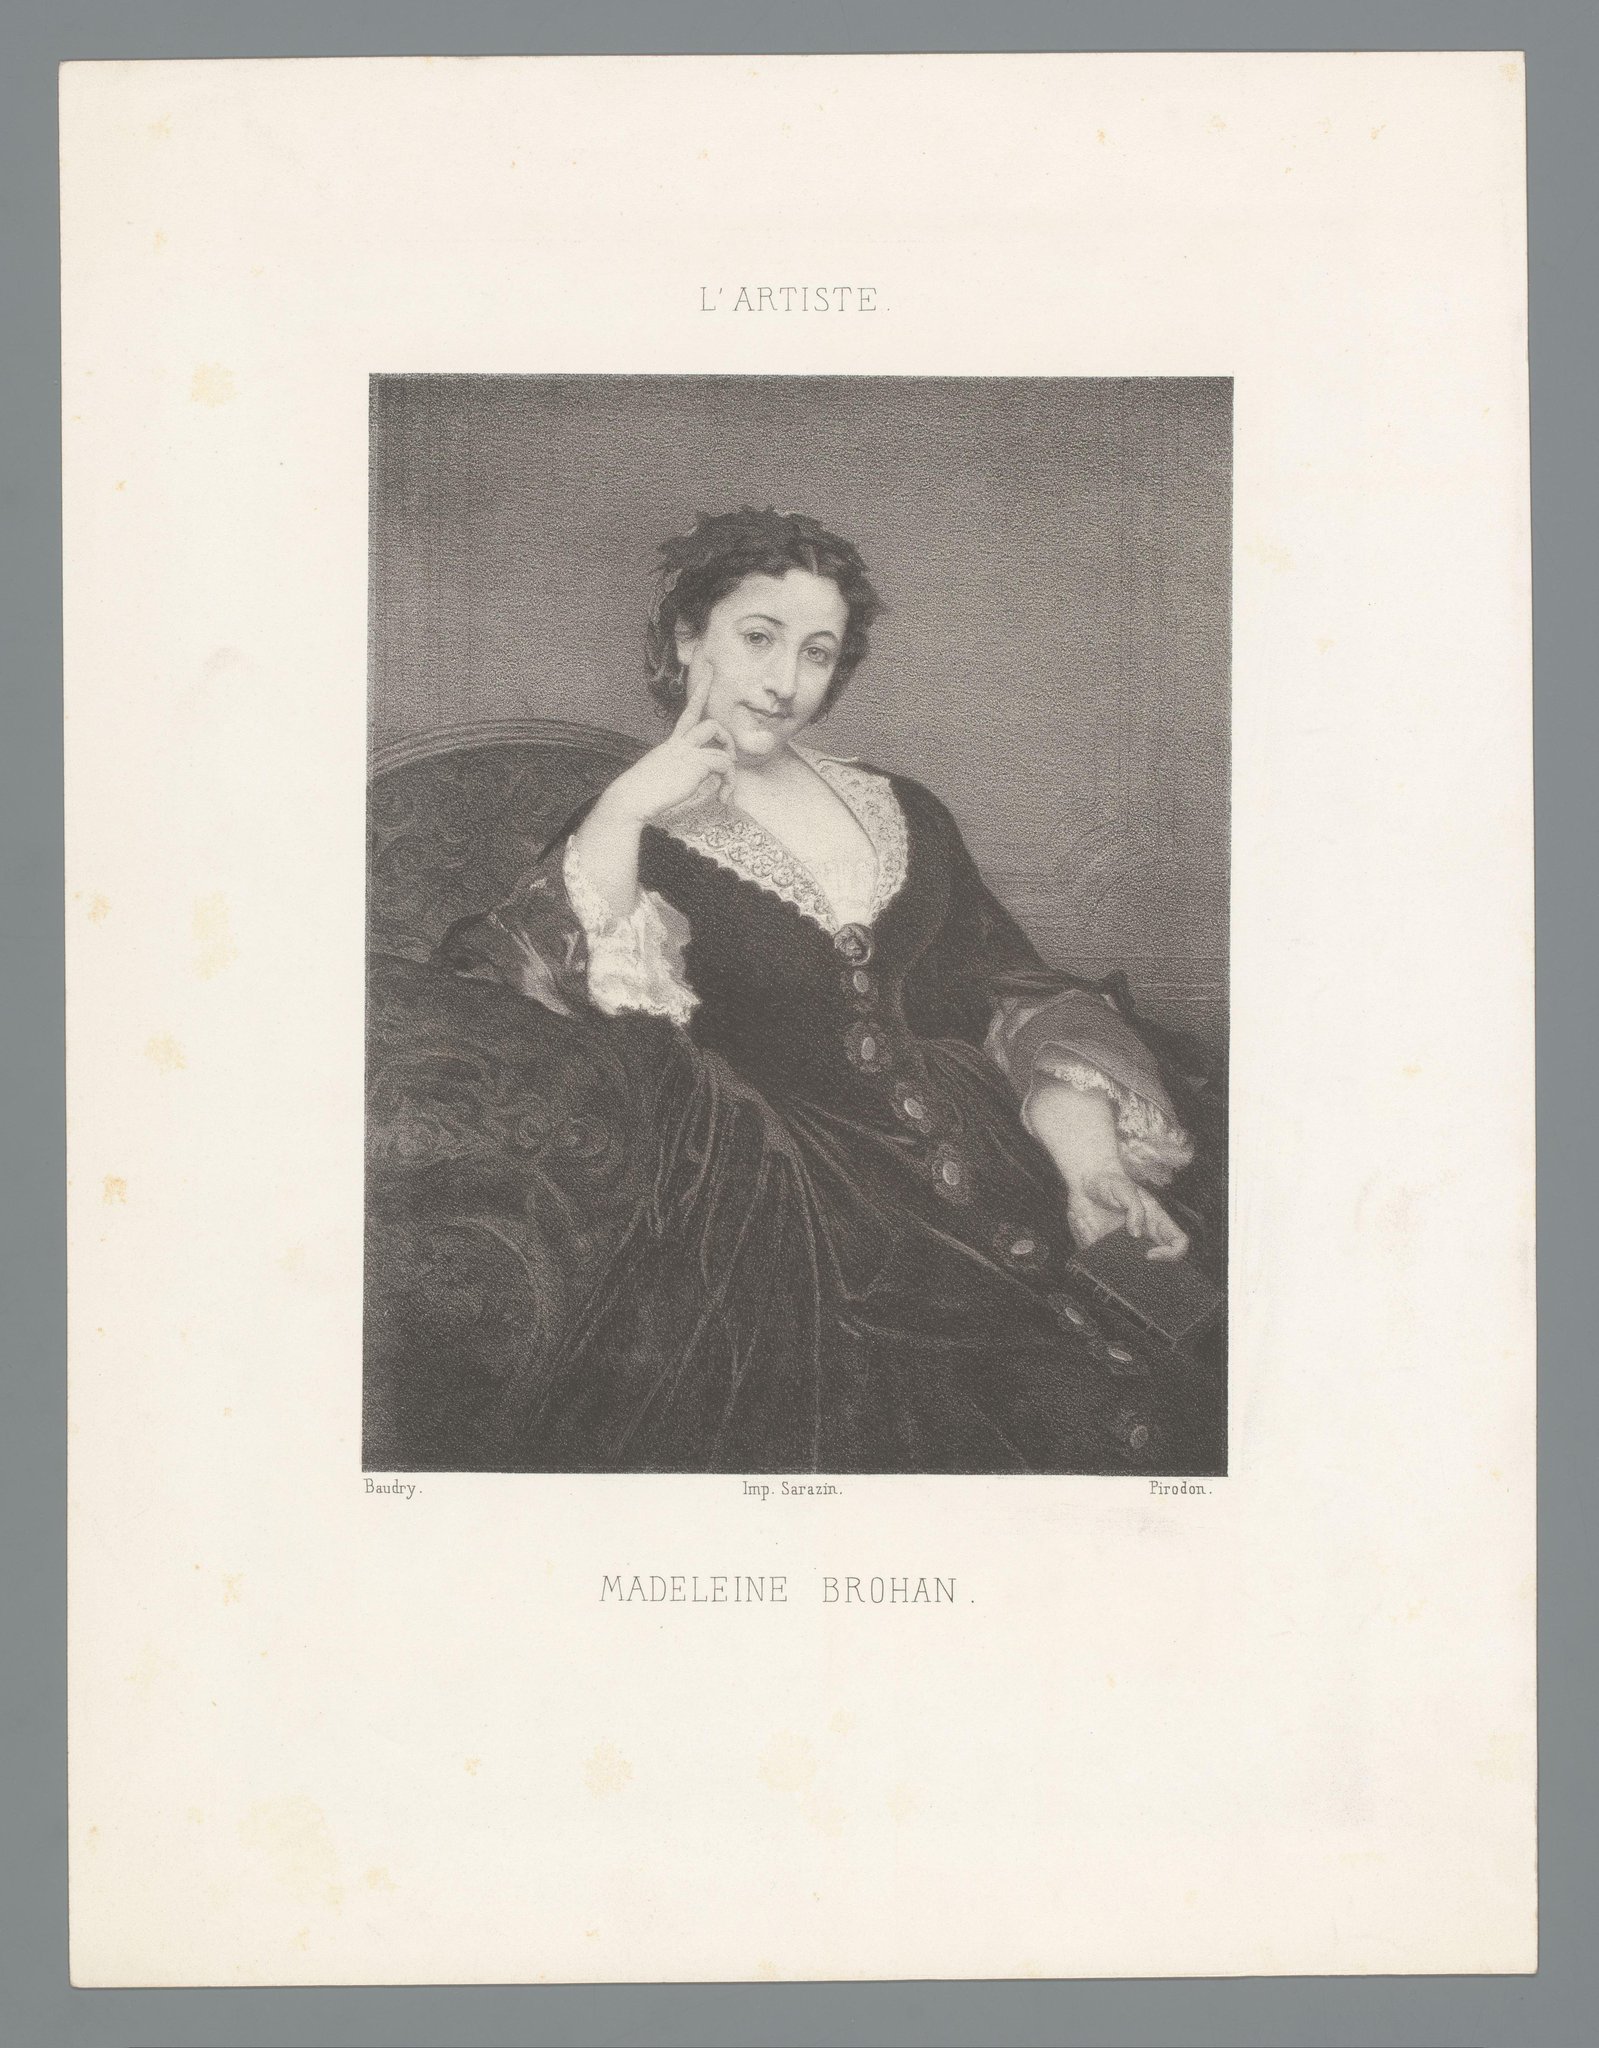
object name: print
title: Portret van actrice Madeleine Brohan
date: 1862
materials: paper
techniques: lithograph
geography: paris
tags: historical persons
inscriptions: collector's mark: Lugt 2228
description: Prent gebruikt in: L'Artiste, 1862, dl. 1.